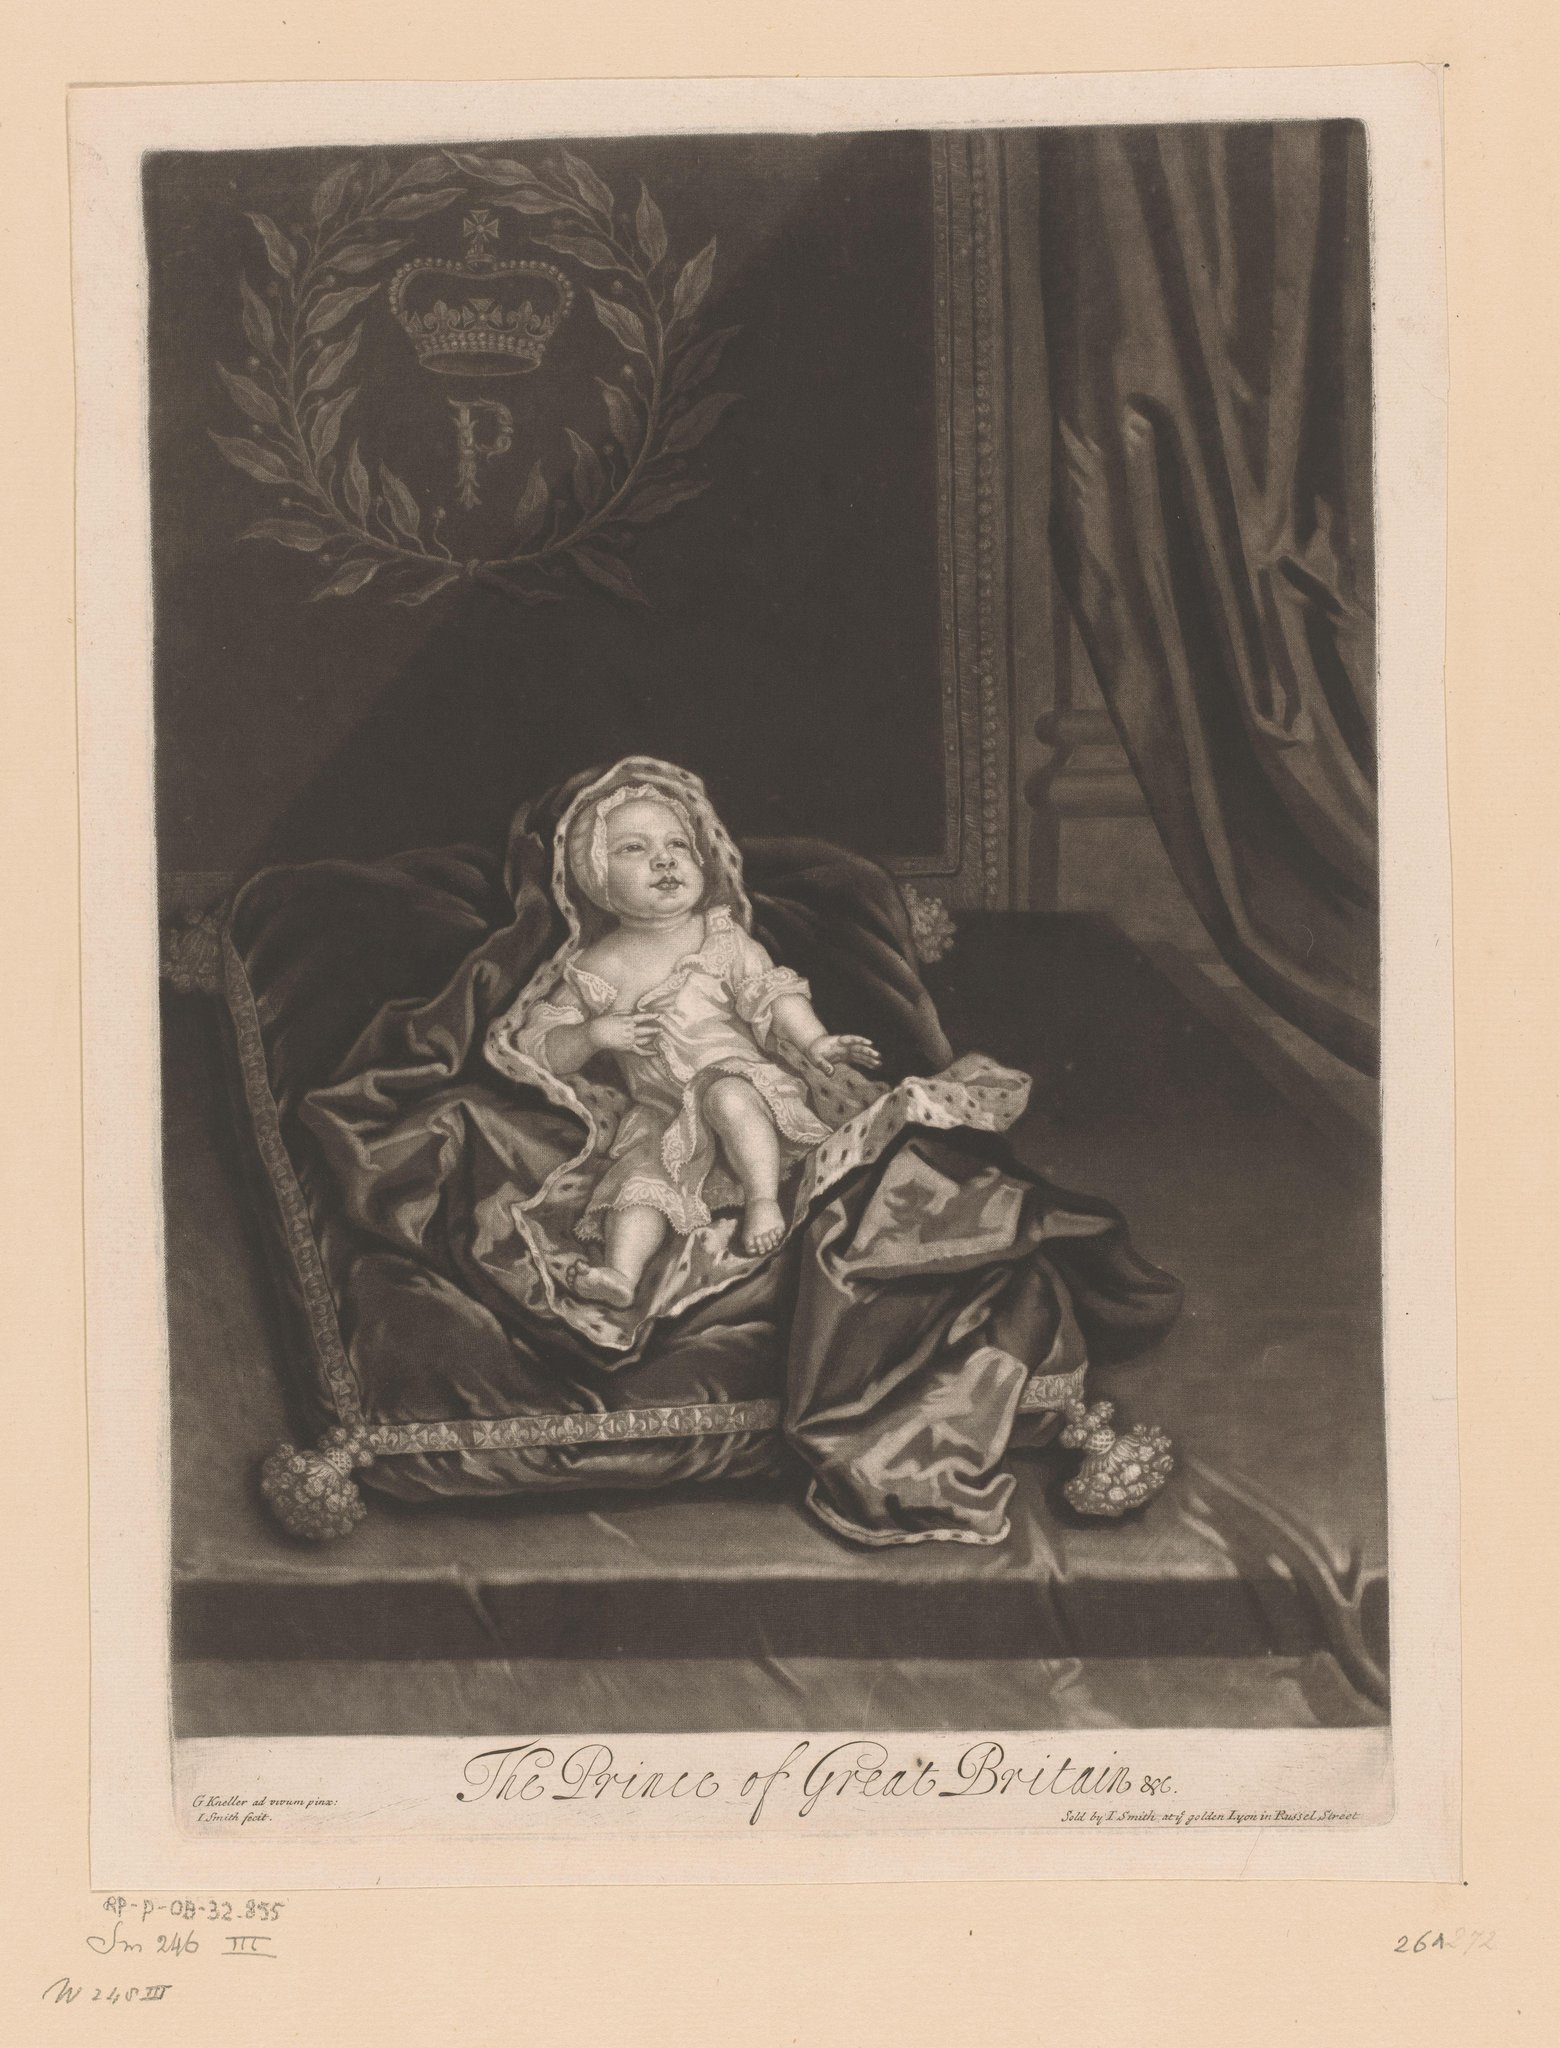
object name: print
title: Portret van Jacobus Frans Eduard Stuart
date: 1689-1742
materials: paper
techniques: mezzotint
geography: london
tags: london, rome, prince, historical persons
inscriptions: collector's mark: Lugt 240